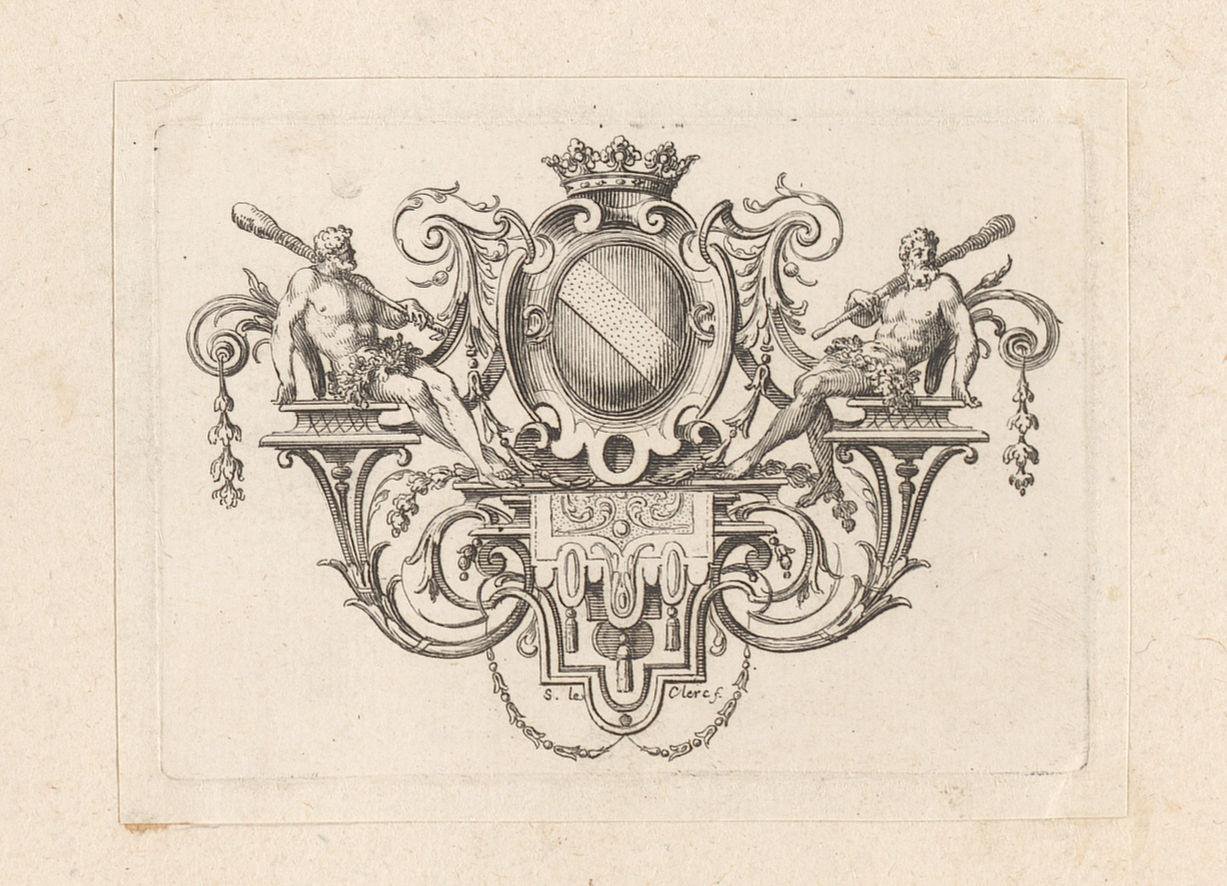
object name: print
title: Cul-de-lampe met het wapen van Noailles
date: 1707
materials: paper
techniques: etching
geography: paris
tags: armorial bearing, heraldry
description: Prent uit: Noailles, Jules-Adrien de. Theses philosophicae (...). Parijs: Jacques Quillau, 1707.